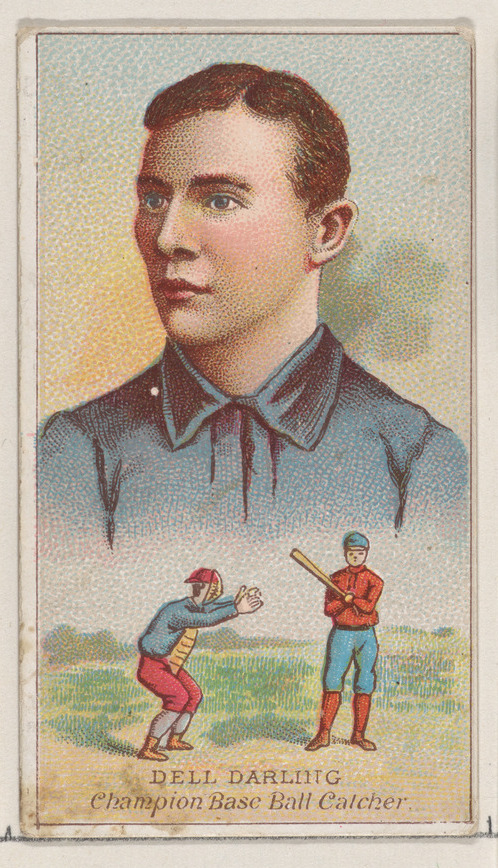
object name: print, baseball card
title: Dell Darling, Champion Baseball Catcher, from the Champions of Games and Sports series (N184, Type 2) issued by W.S. Kimball & Co.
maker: w.s. kimball & co.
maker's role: publisher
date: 1887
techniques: color lithograph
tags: men,baseball,athletes